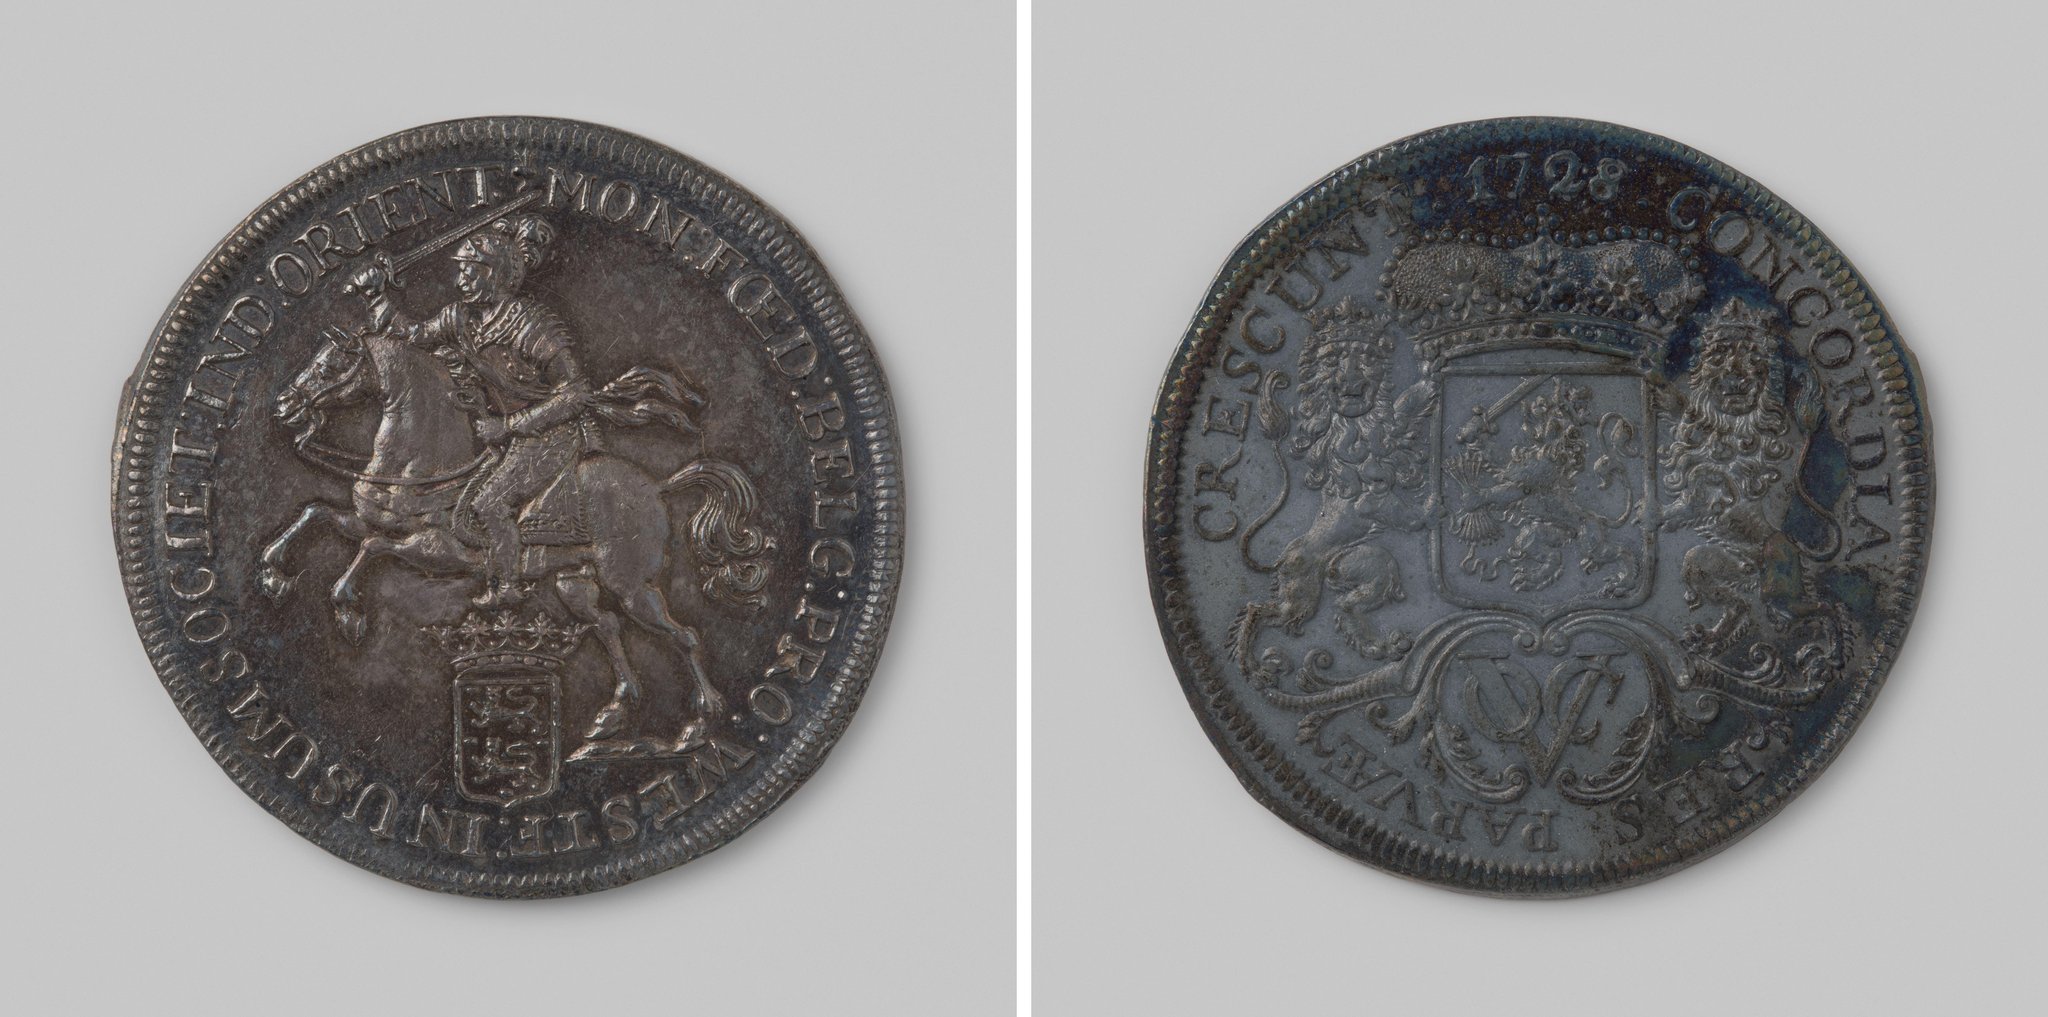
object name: coin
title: Zilveren rijder van West-Friesland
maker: jan knol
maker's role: mintmaster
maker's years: 1715-1751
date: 1728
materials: silver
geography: hoorn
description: Voorzijde: geharnaste ruiter, naar links, hierboven gekroond wapen. Geheel binnen omschrift: MON : FOED : BELG : PRO : WESTF : INUSUM : SOCIET : IND : ORIENT :. Keerzijde: generaliteitswapen tussen 2 staande leeuwen, Geheel binnen omschrift: CONCORDIA RES PARVAE CRESCUNT . 1728.